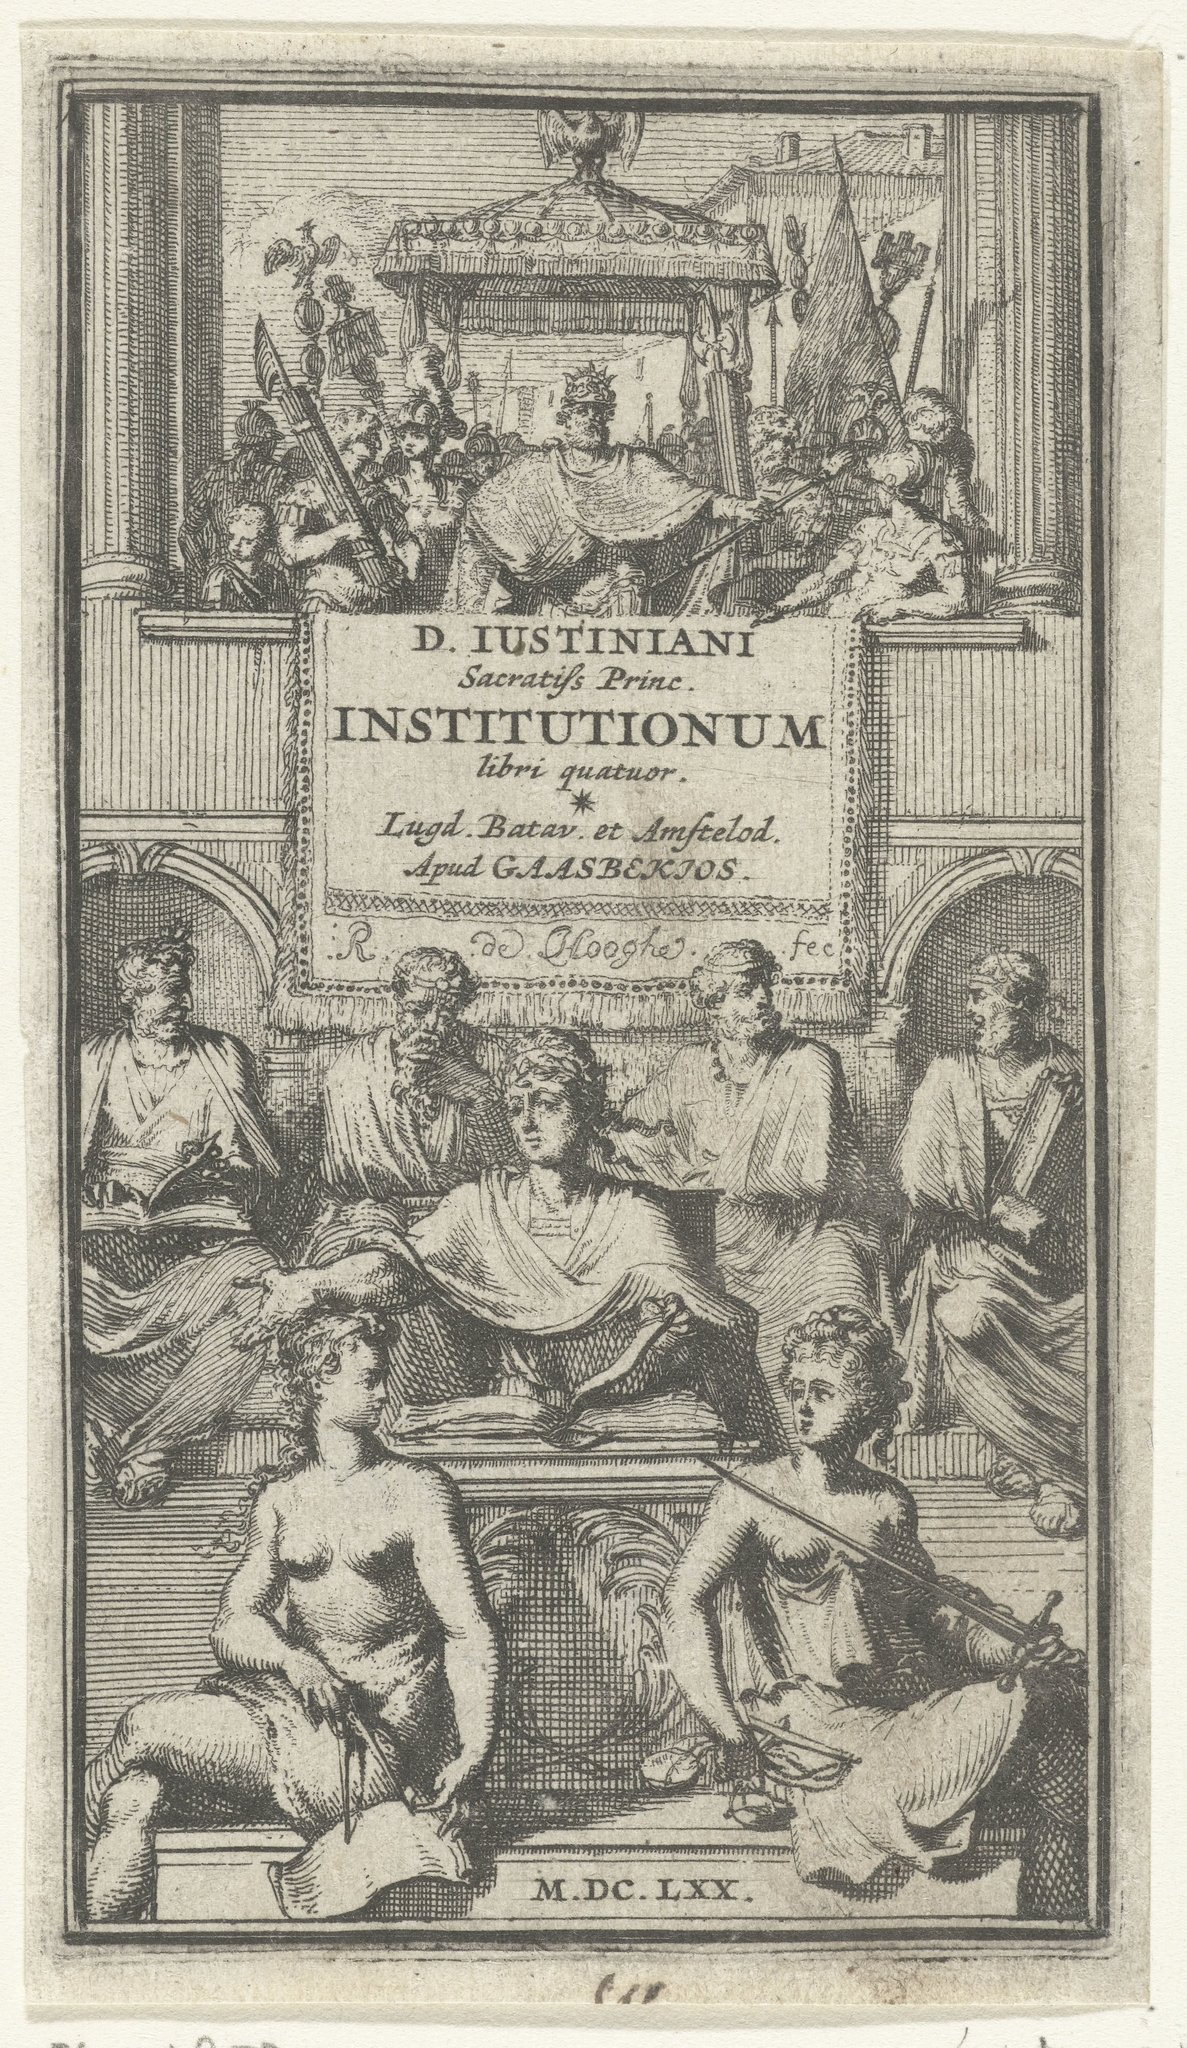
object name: book illustration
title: Titelprent voor 'Institutionum libri quatuor' van Justinianus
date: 1670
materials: paper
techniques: etching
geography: amsterdam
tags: 'geometria' (~ quadrivium); 'geometria' (ripa), justitia (justice) as roman personification, scholastic education, tuition (+ teacher, professor), emperor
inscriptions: collector's mark: Lugt 2228a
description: Een keizer troont, omringd door soldaten en/of onderdanen, onder een baldakijn op een podium of galerij, vanaf welke hij uitzicht heeft op een figuur achter een lezenaar en vier andere wijze mannen. Voor de lezenaar twee allegorische vrouwenfiguren: Meetkunde (met passer) en Gerechtigheid (met zwaard en weegschaal).